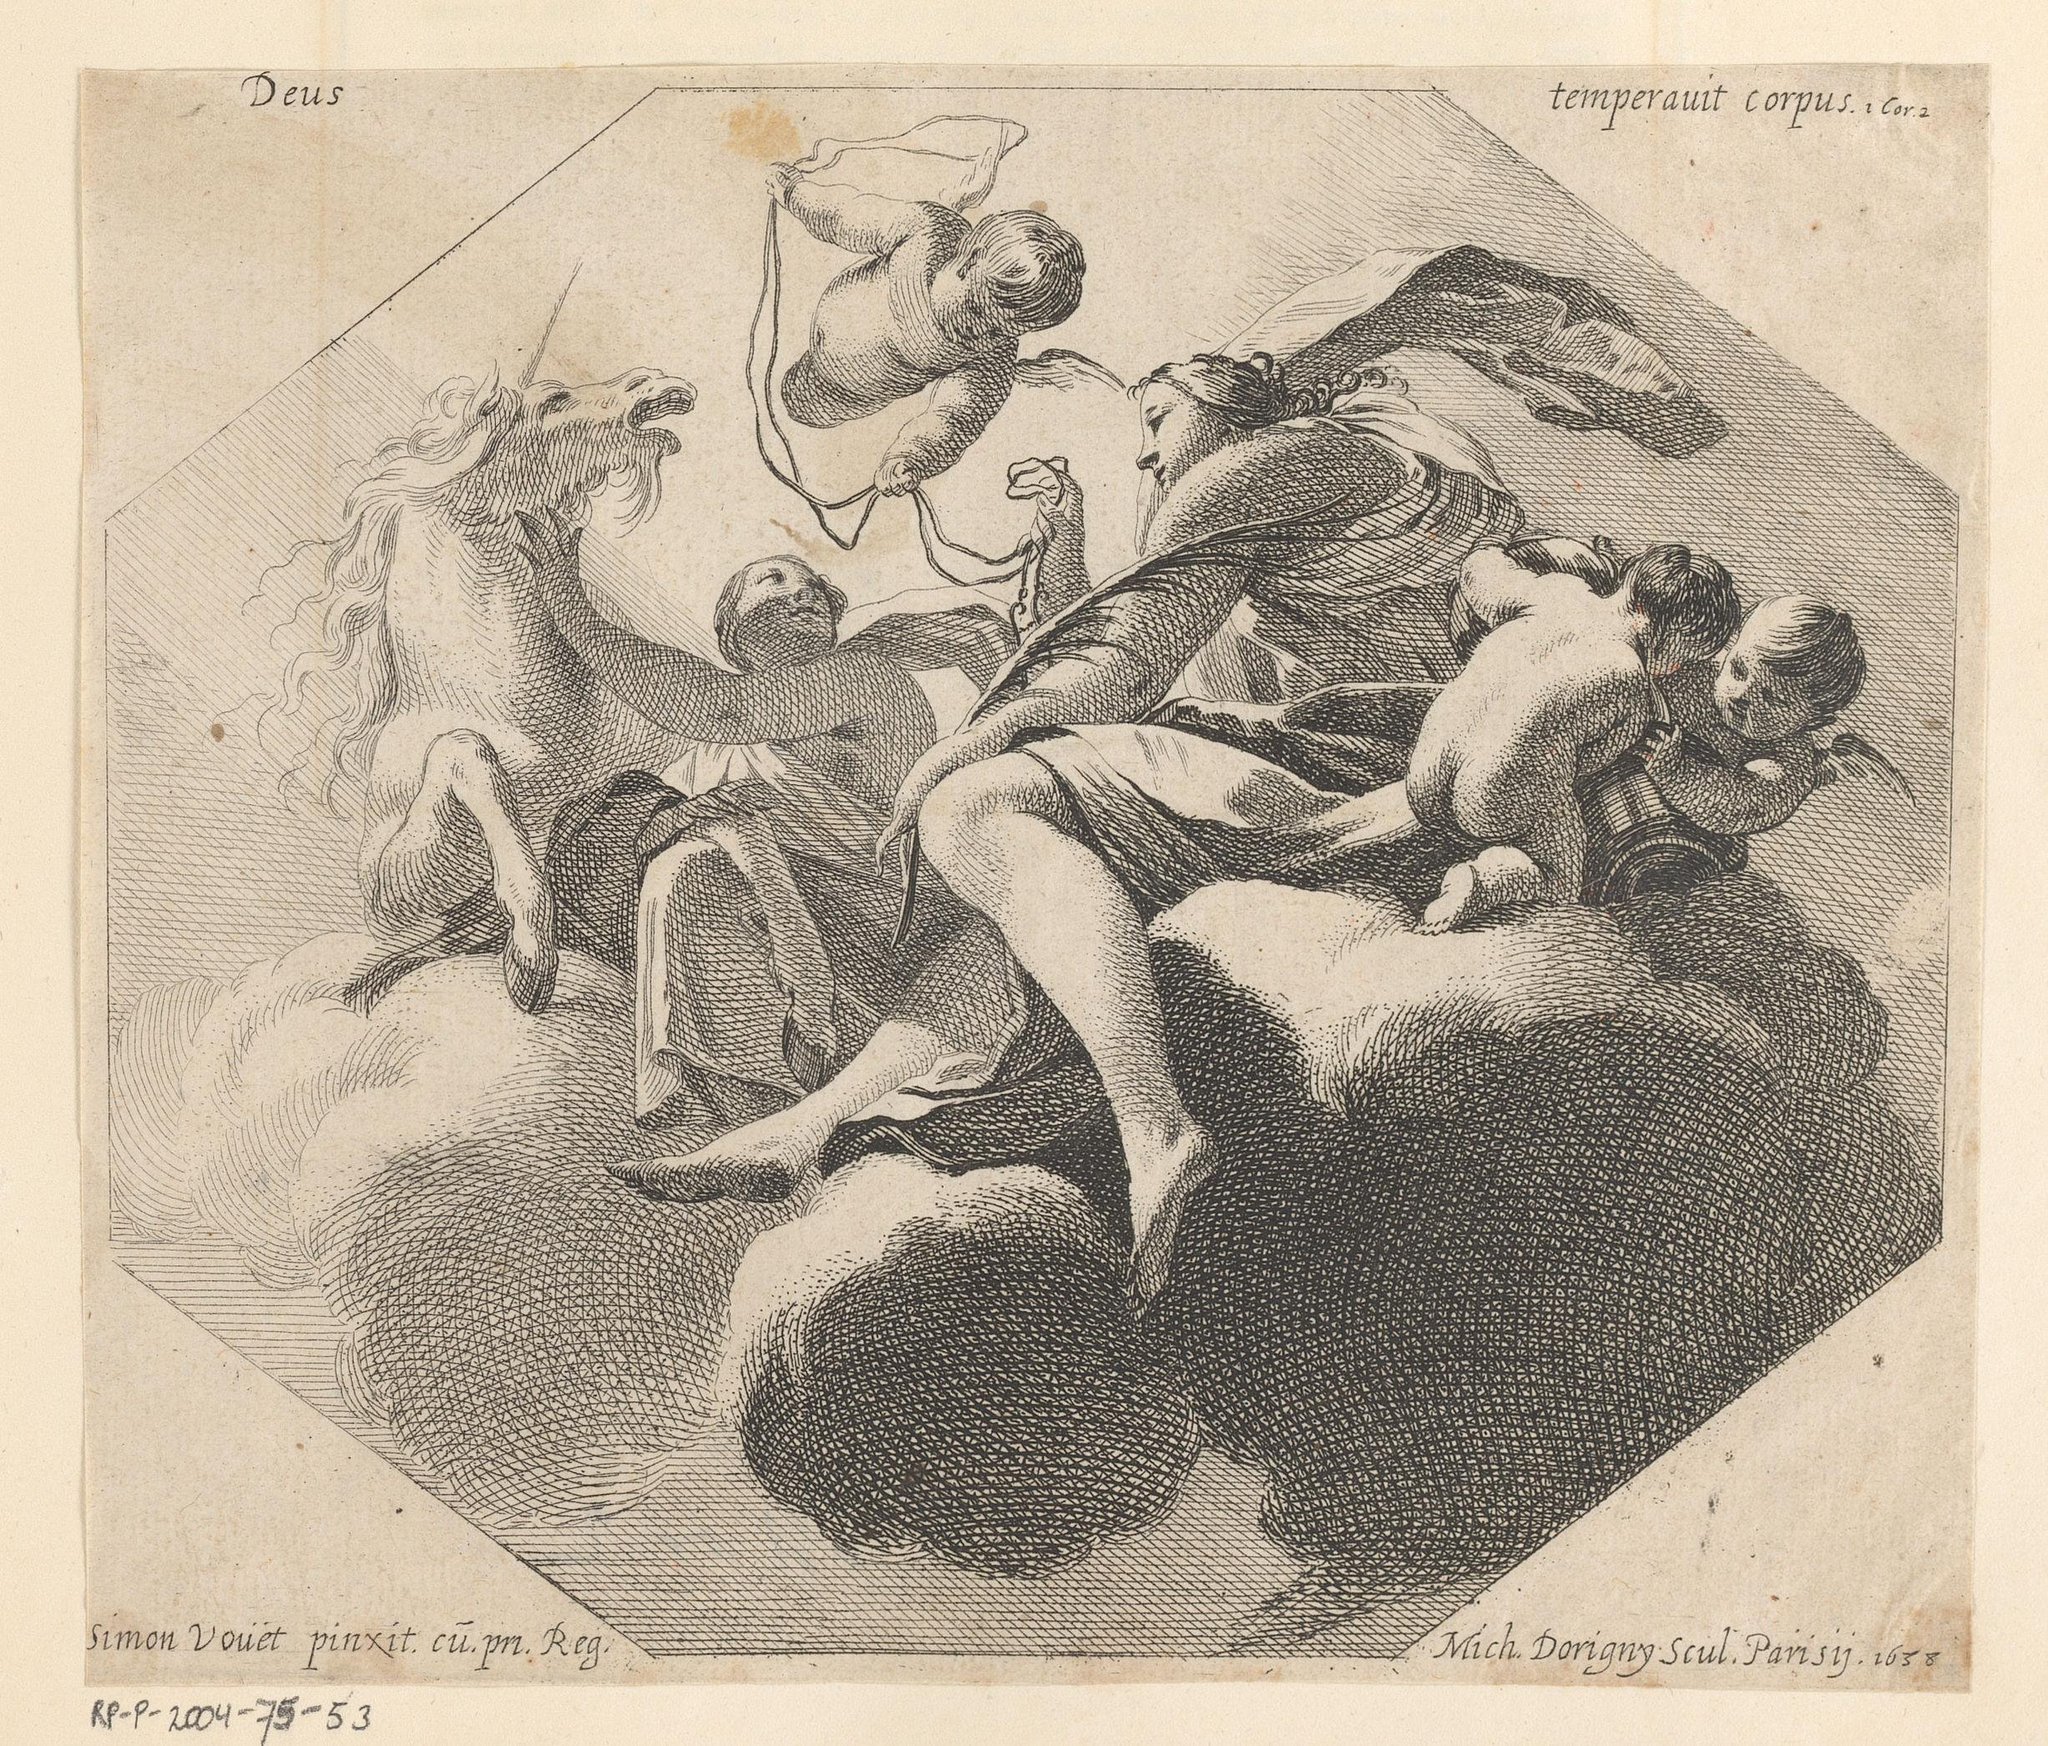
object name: album leaf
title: Kardinale deugden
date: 1638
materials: paper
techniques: engraving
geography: paris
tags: temperance, 'temperantia'; 'temperanza' (ripa) ~ one of the four cardinal virtues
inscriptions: date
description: De samensteller heeft deze prent in het album geplakt als illustratie bij: Pilkington, Matthew en Johann Heinrich Füssli. A dictionary of painters, from the revival of the art to the present period. 4 dln. Londen: John Crowder, 1805, dl. 4, p. 632.